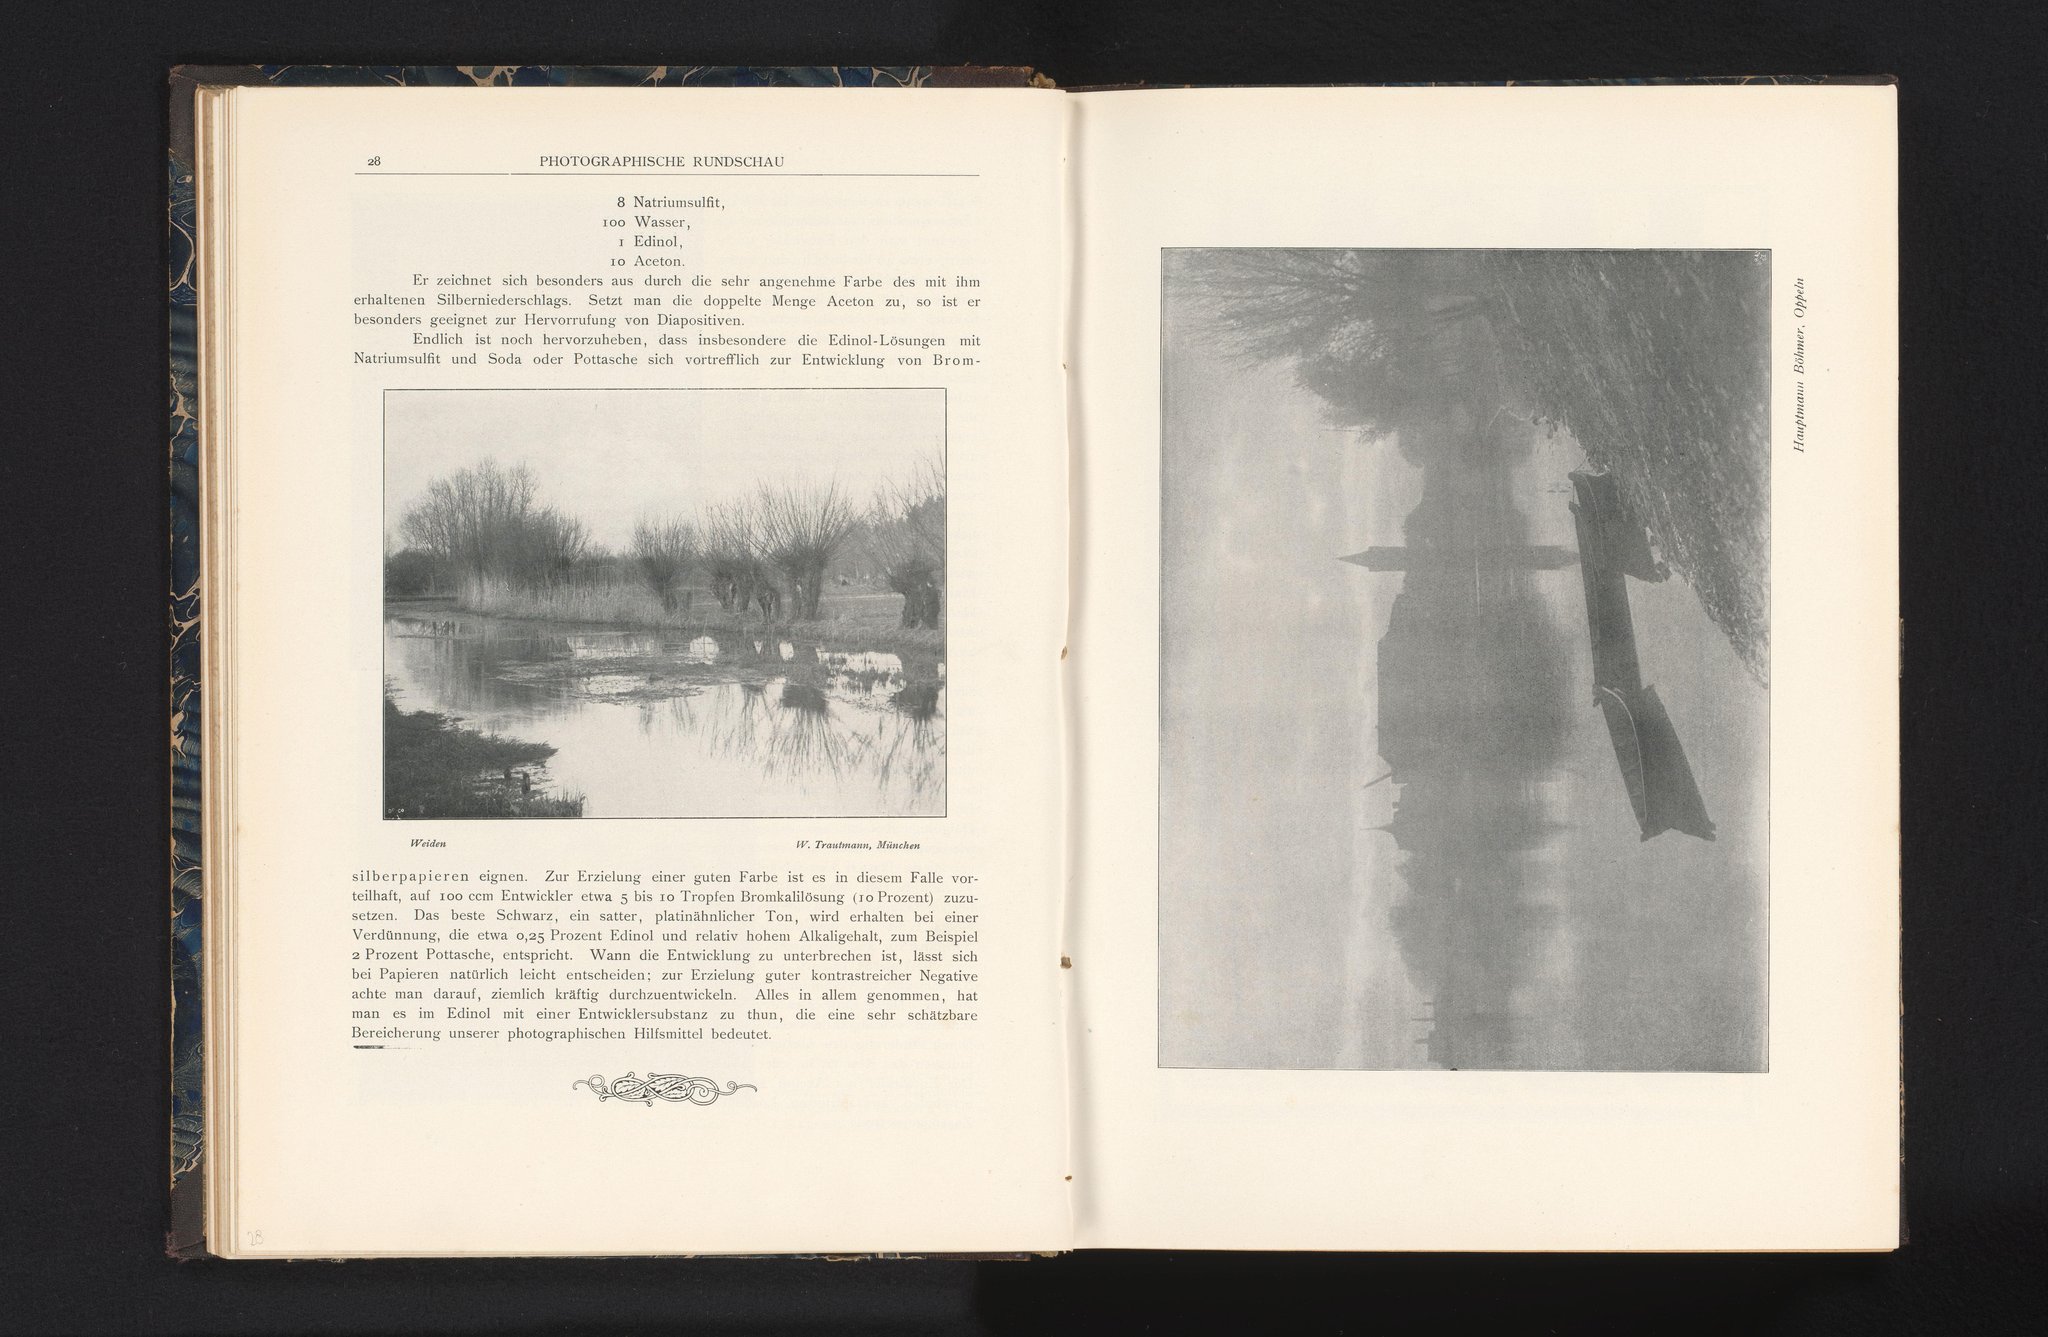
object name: page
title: Weiden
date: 1897-1902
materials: paper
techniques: autotype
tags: trees, landscapes with waters, waterscapes, seascapes (in the temperate zone)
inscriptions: monogram: ‘drAco’